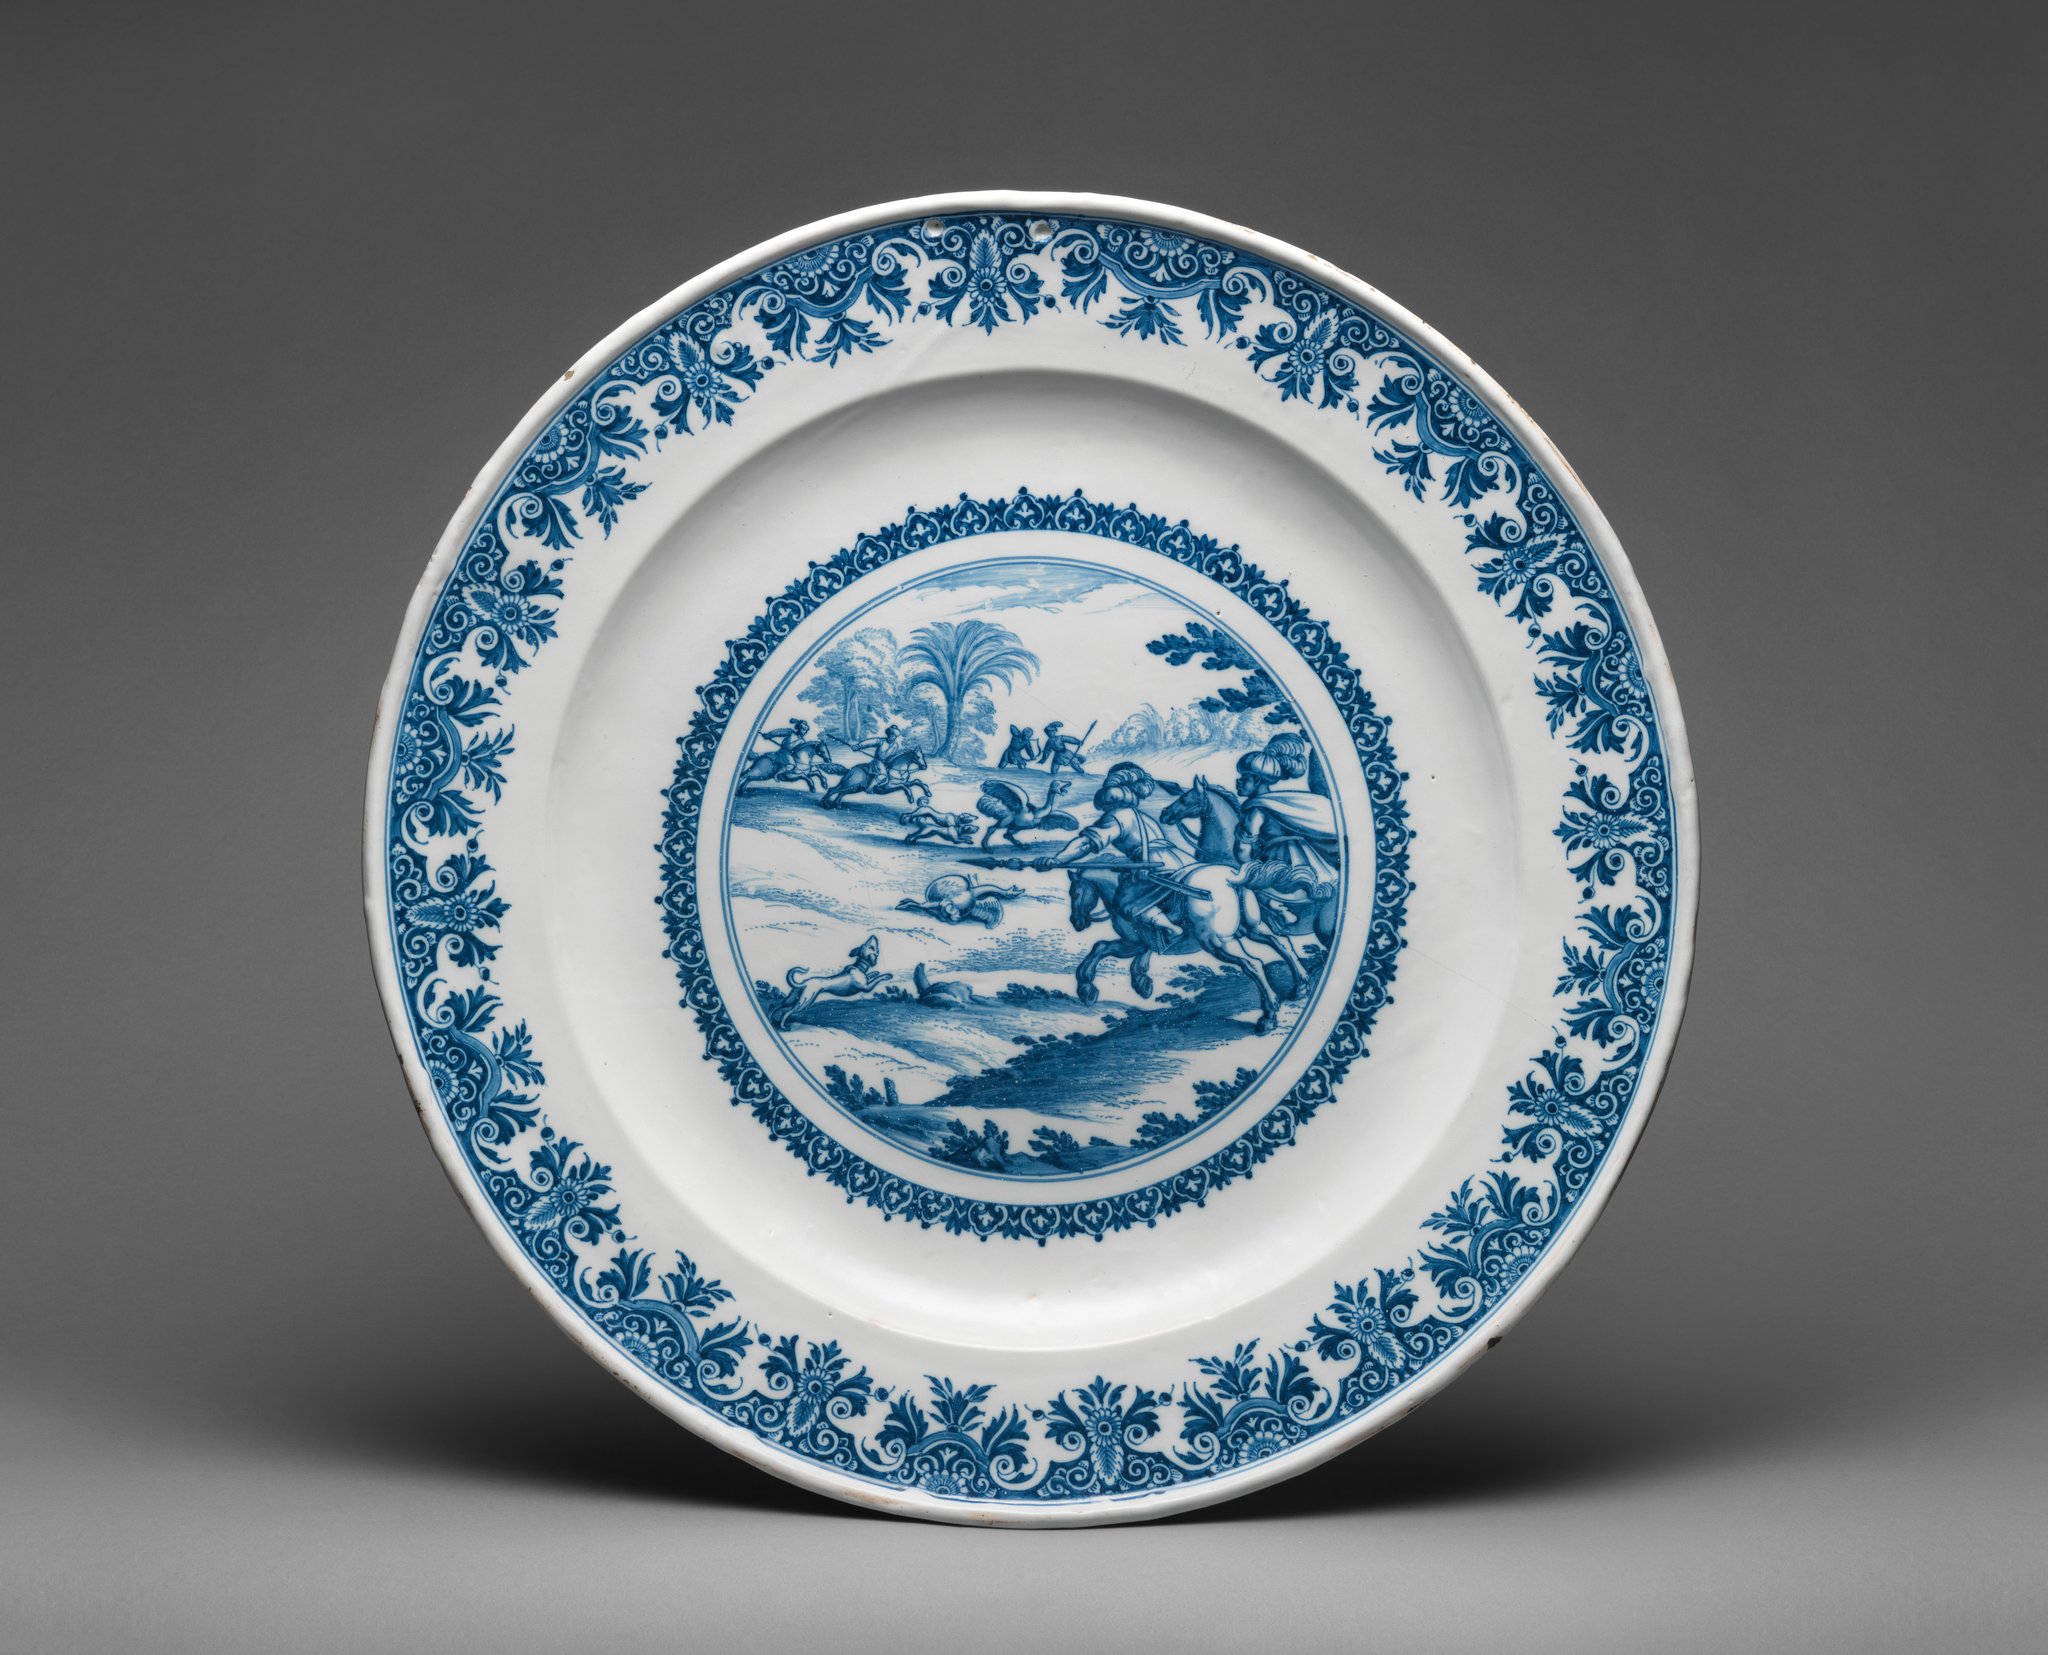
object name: plateau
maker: clérissy manufactory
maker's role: manufactory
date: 1700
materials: faience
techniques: glazing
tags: birds,spears,men,hunting,dogs,horses